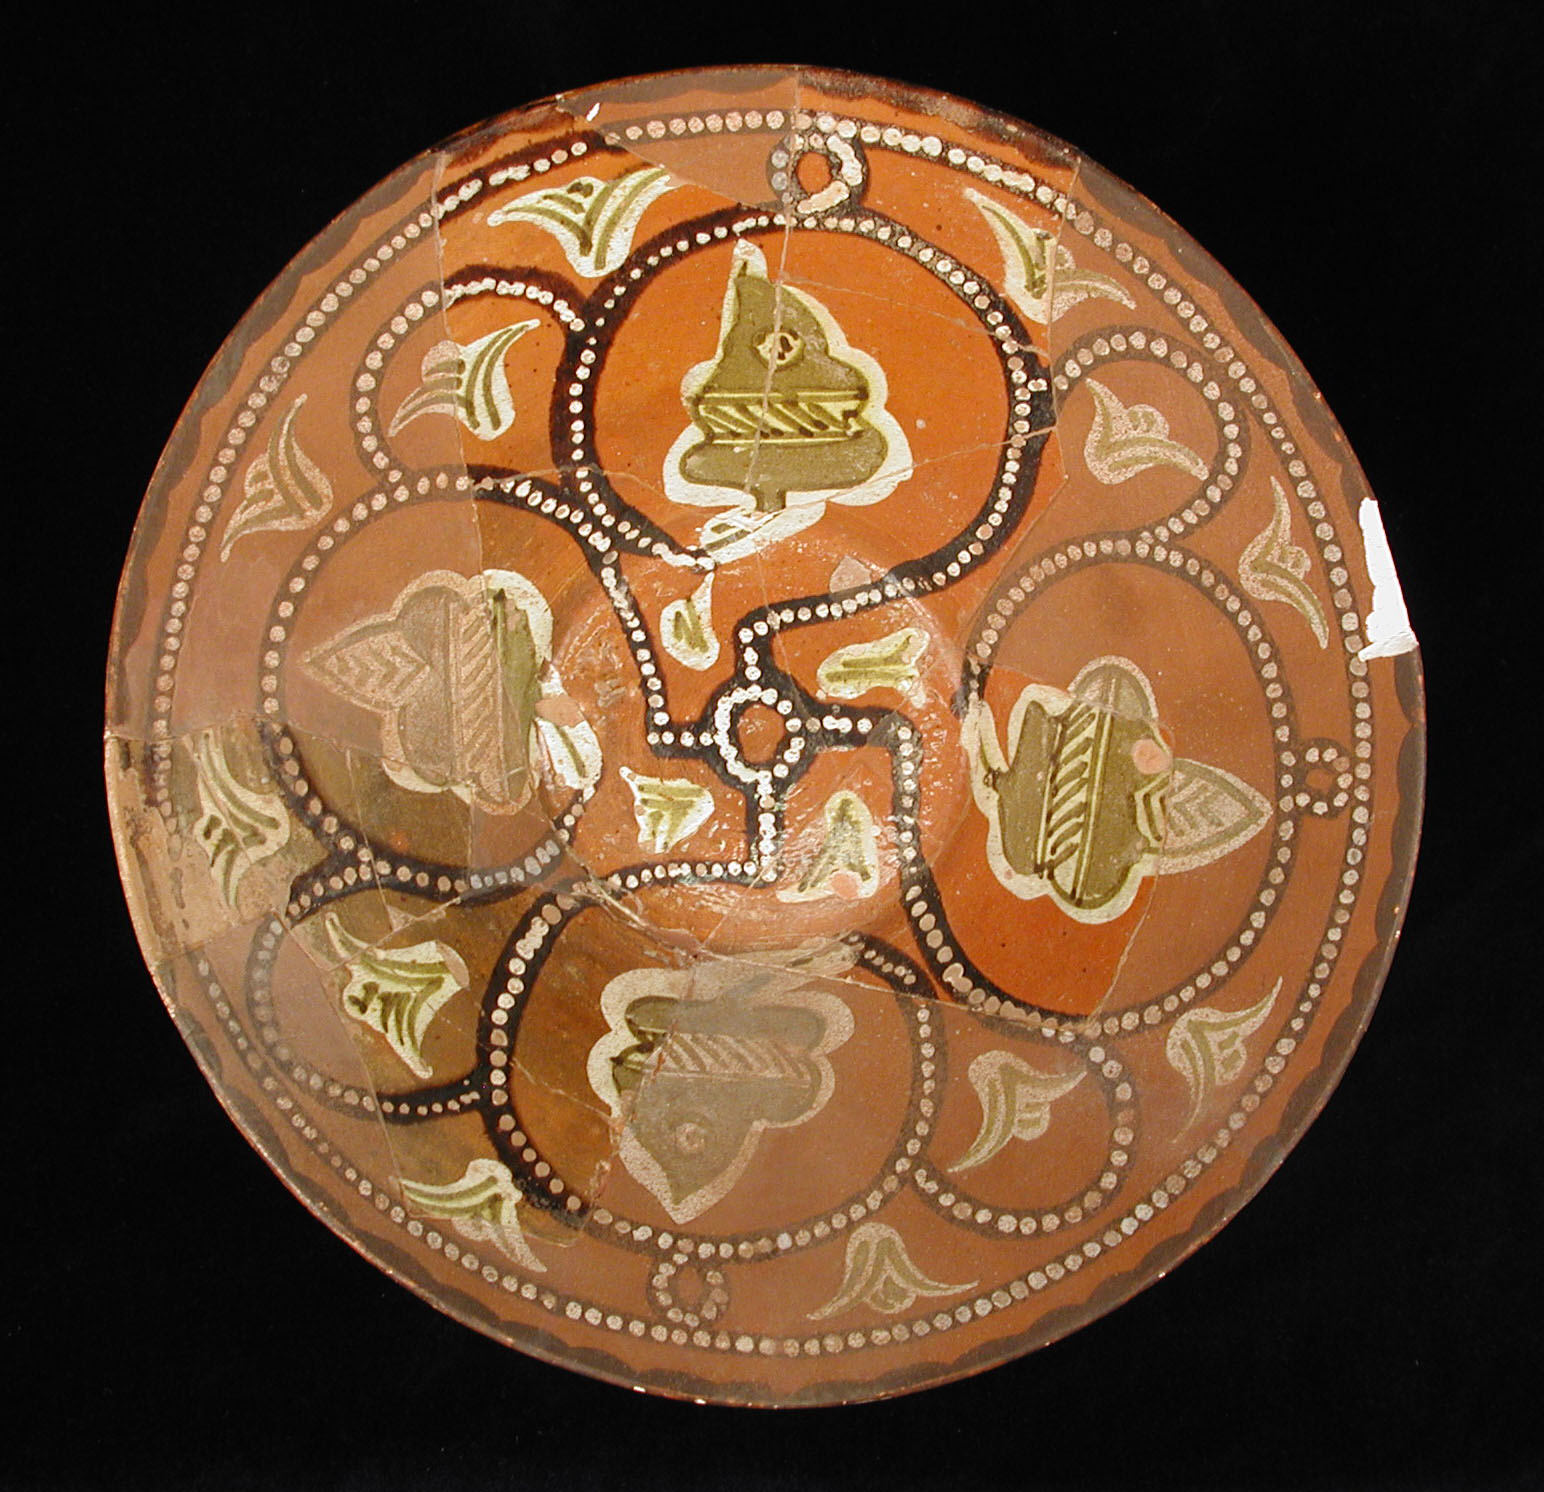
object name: bowl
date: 801-900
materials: earthenware, glaze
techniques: polychrome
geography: iran